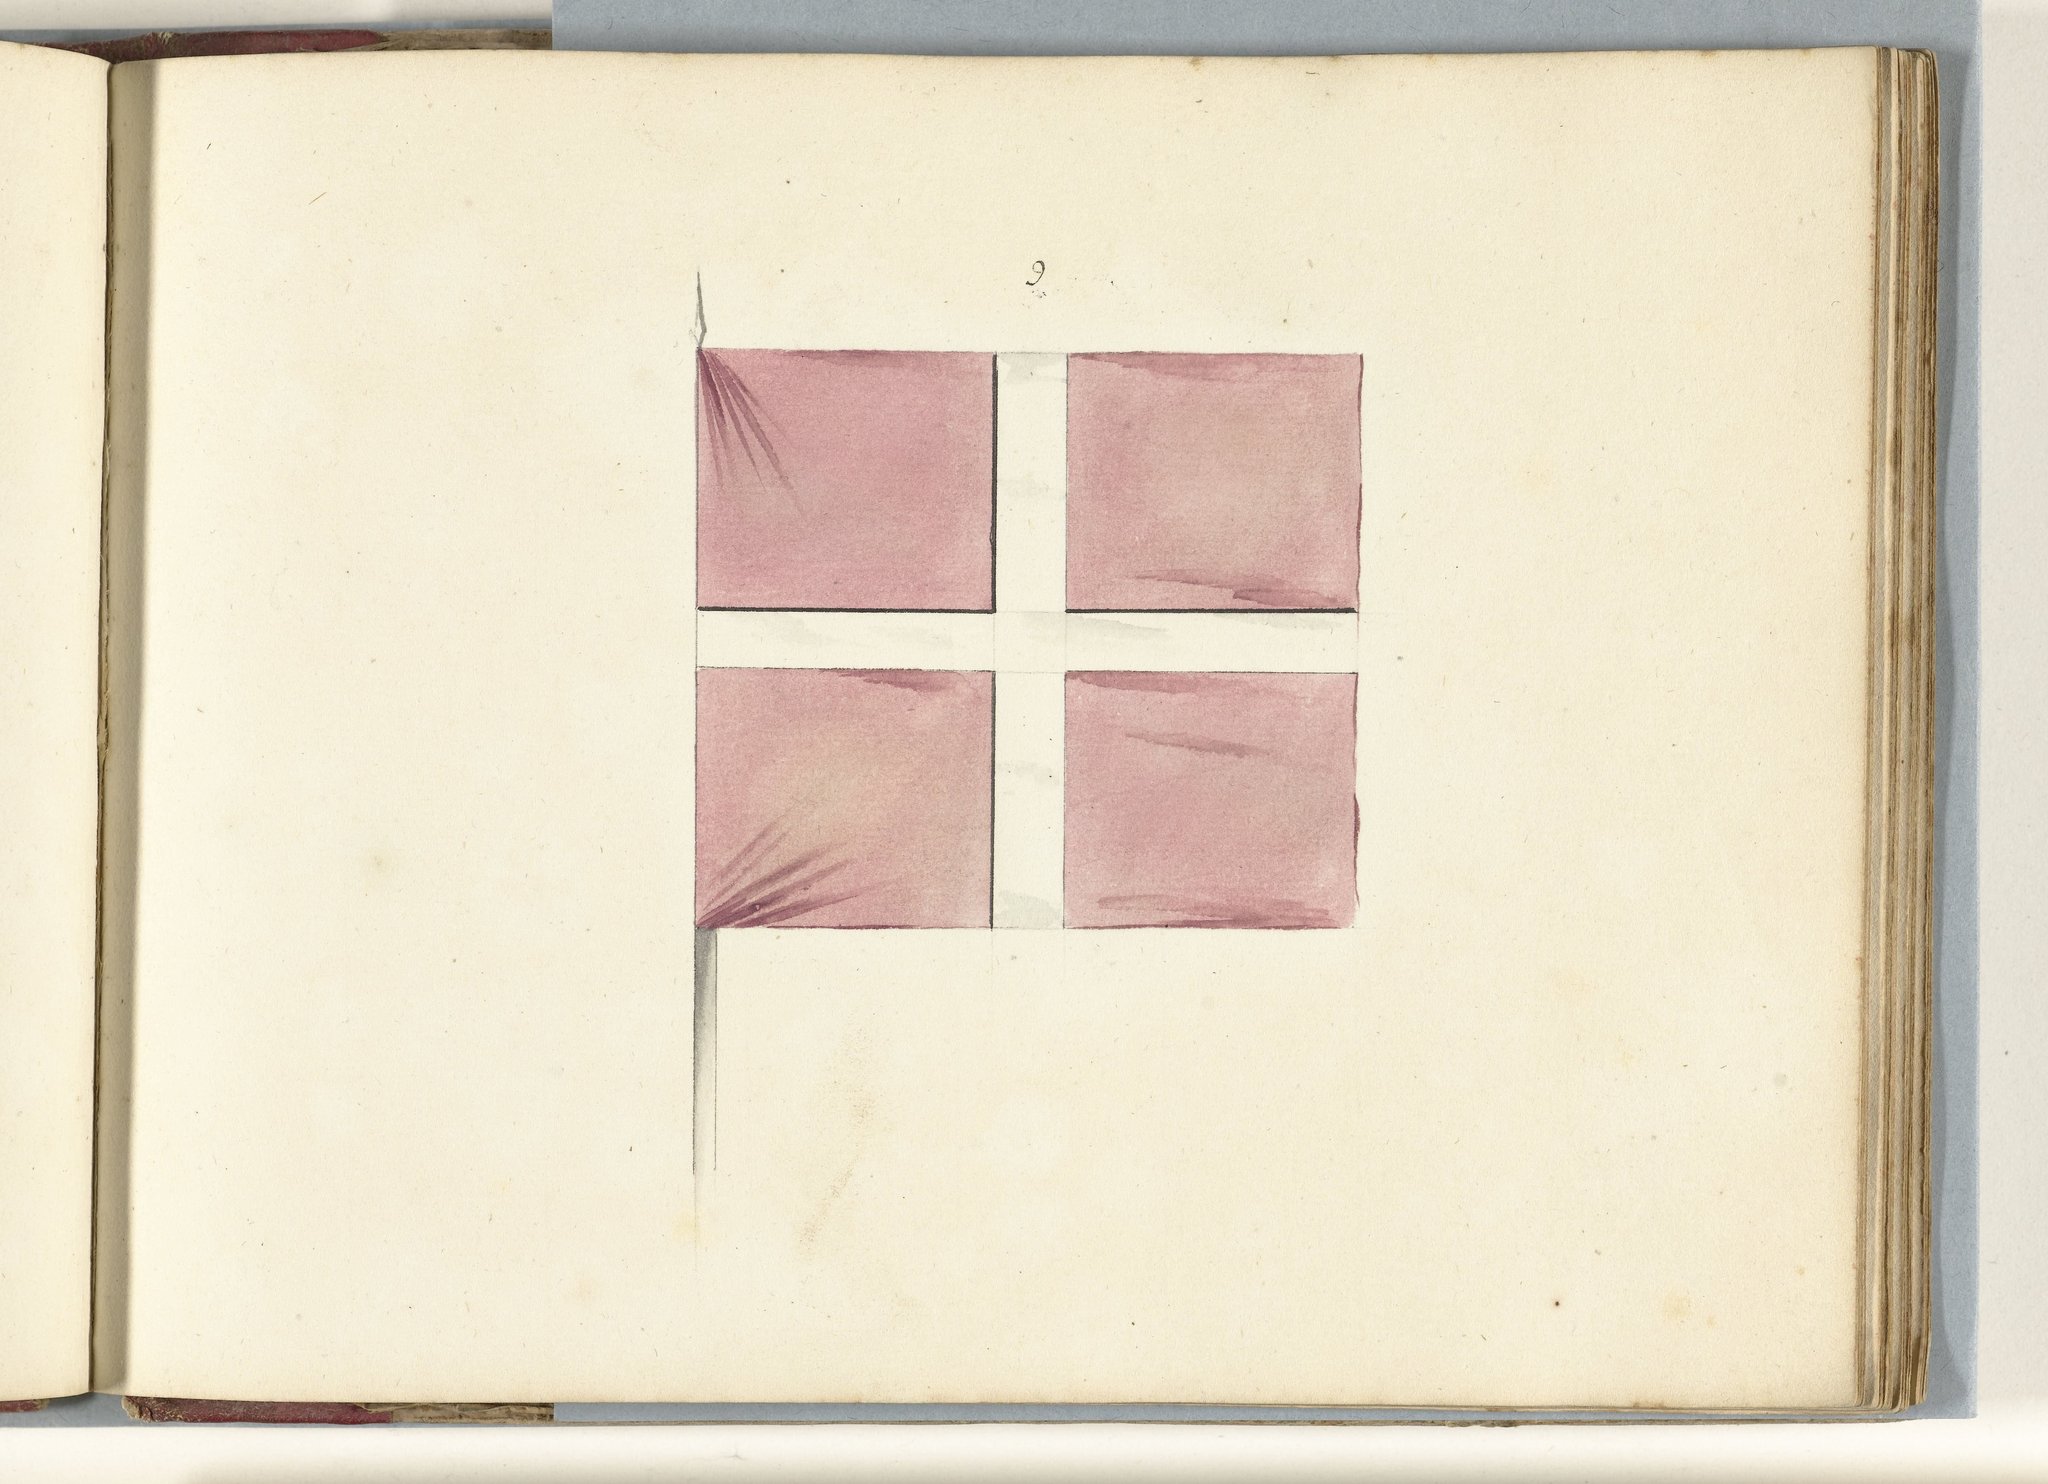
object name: drawing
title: Frans vaandel veroverd in de slag bij Malplaquet, 1709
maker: Anonymous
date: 1713-1720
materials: paper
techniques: drawing, writing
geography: northern netherlands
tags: (military) flags and standards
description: Frans vaandel veroverd bij de slag bij Malplaquet in 1709. In het boek met tekeningen van Franse vaandels, standaarden en pauken, veroverd tijdens de Spaanse Successieoorlog (1701-1713).